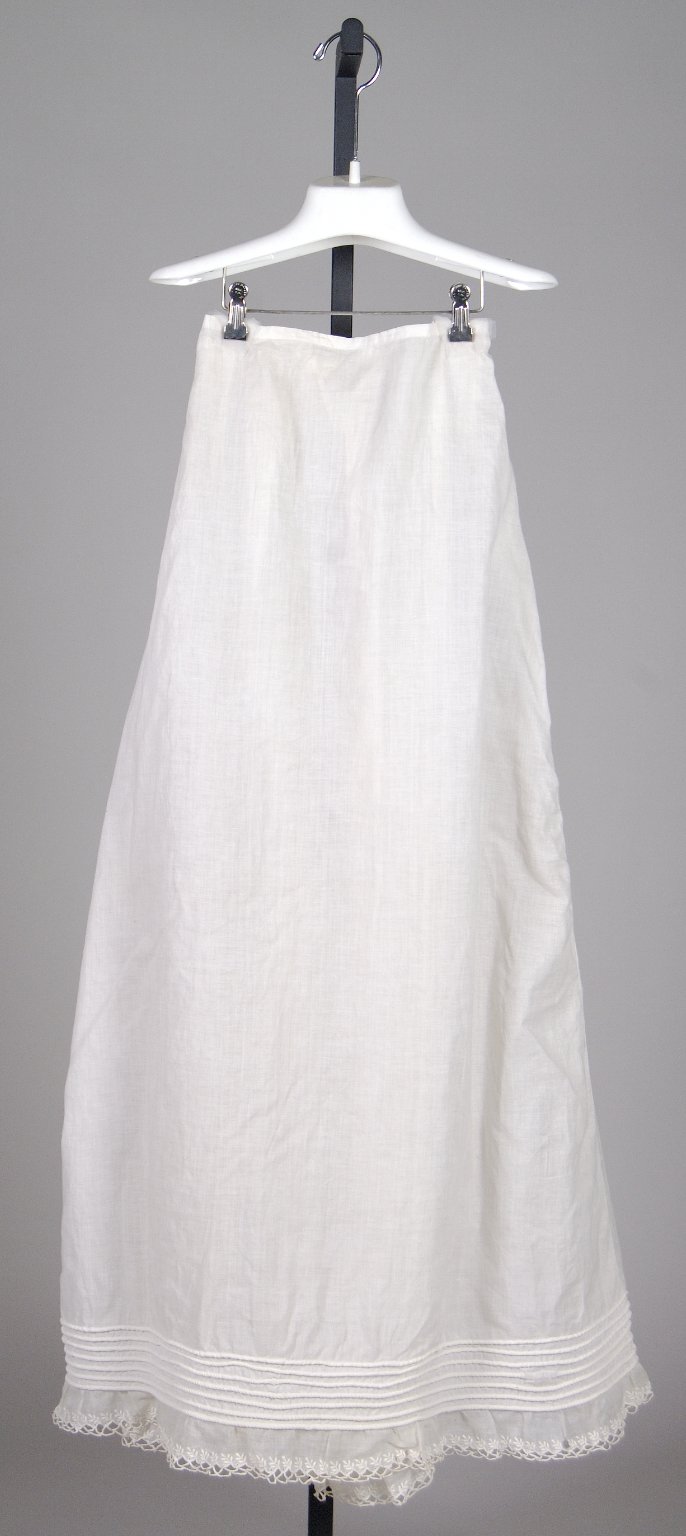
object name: petticoat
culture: british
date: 1820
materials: cotton